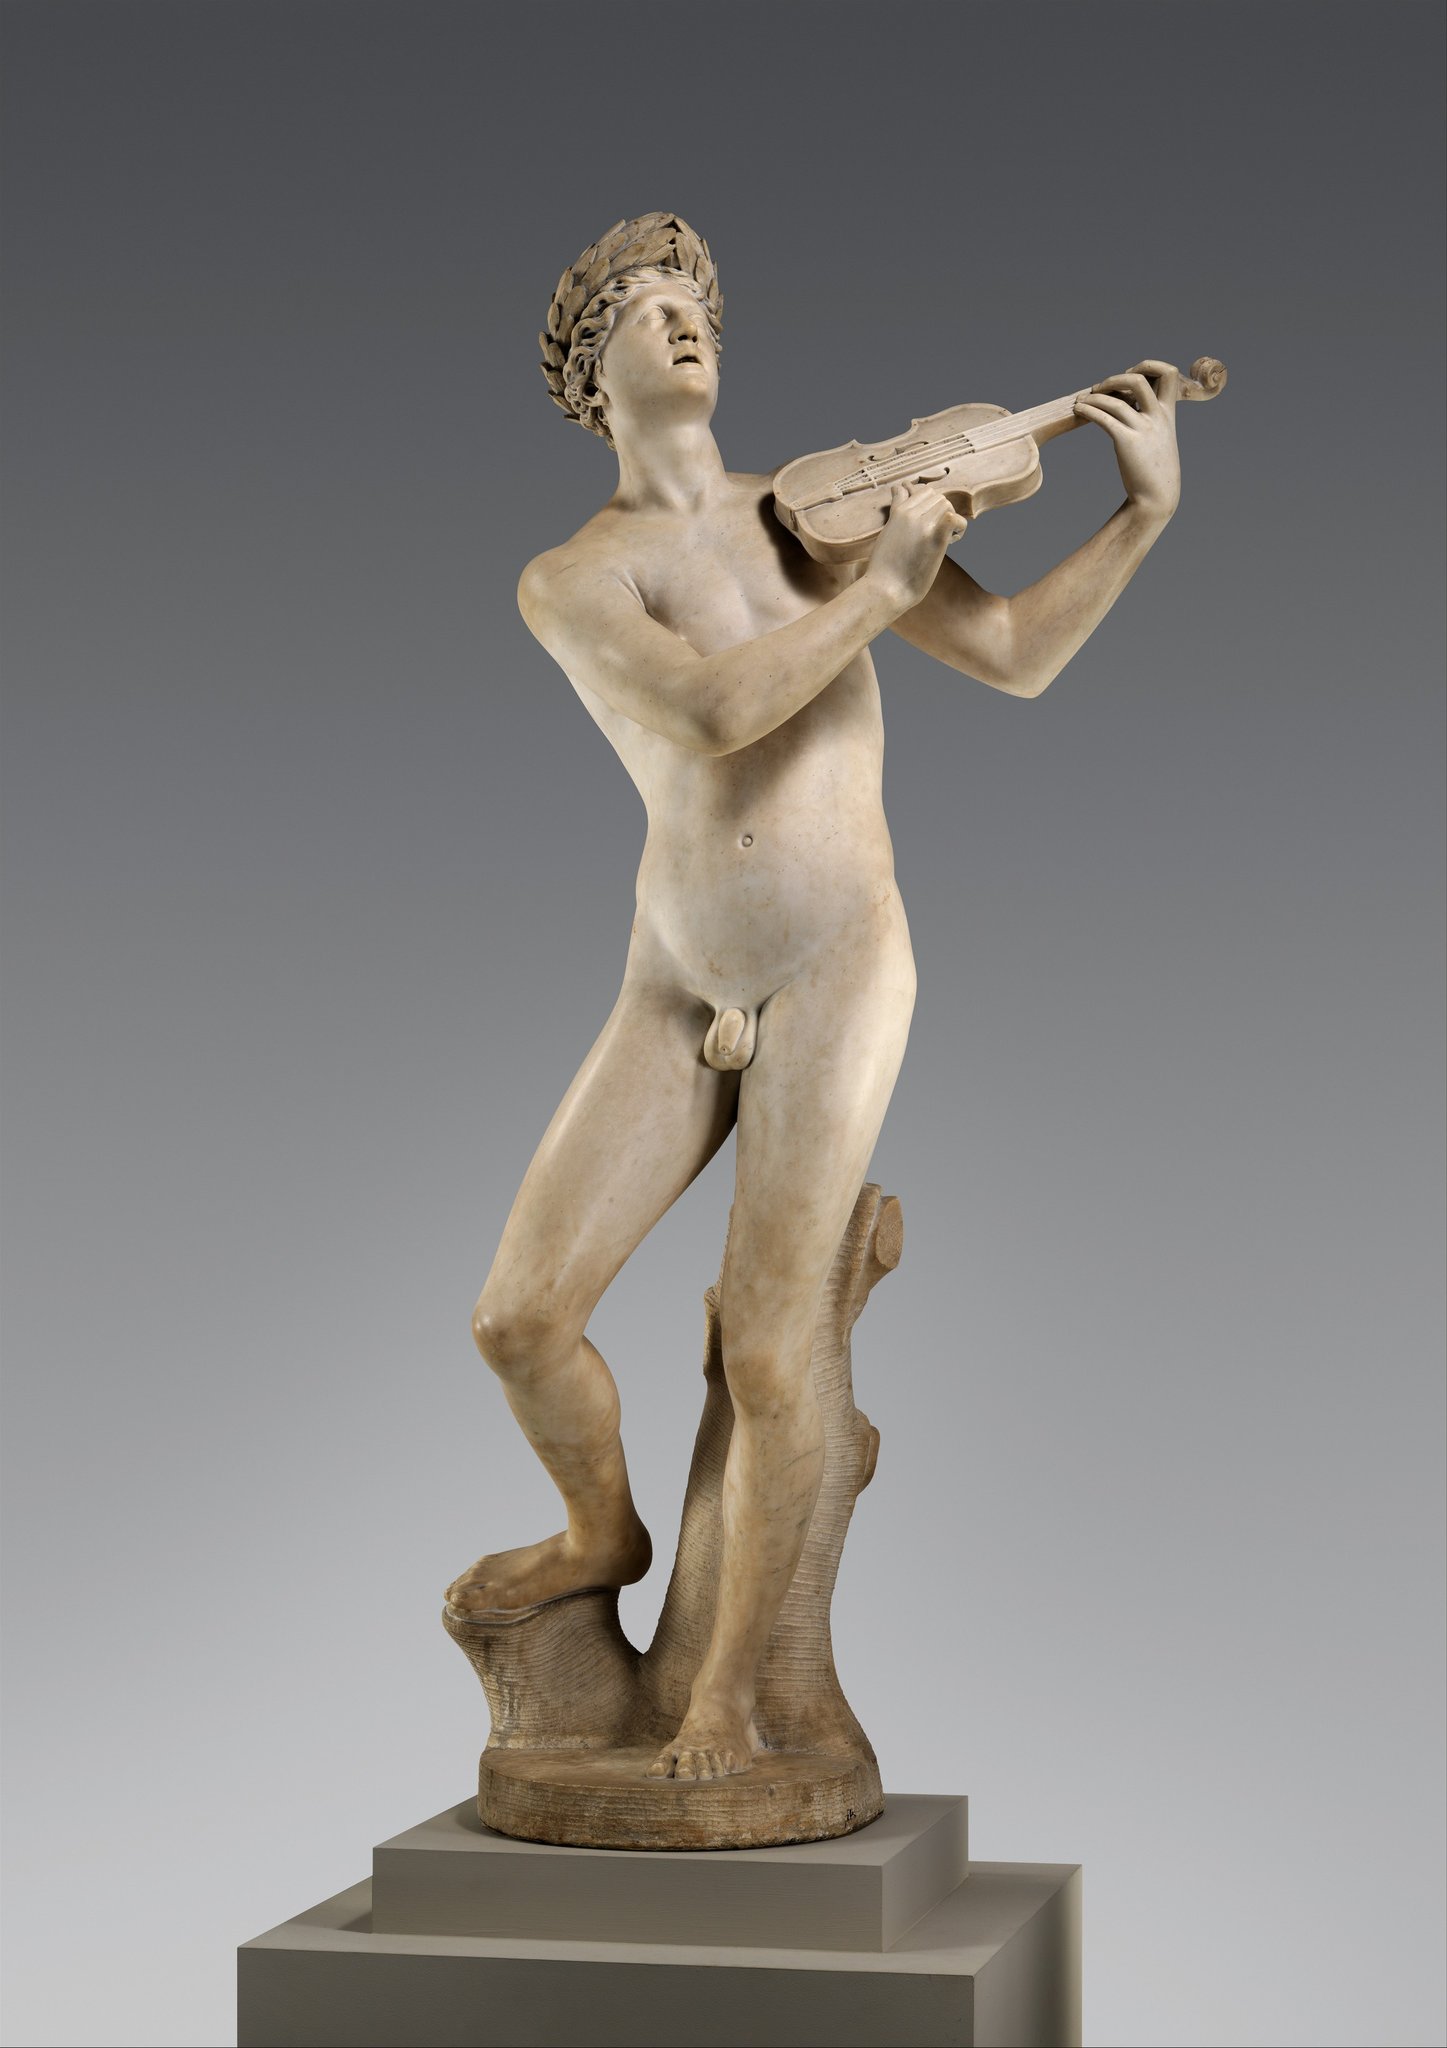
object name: statue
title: Orpheus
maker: cristoforo stati (cristofano da bracciano)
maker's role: artist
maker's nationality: italian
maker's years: 1556-1619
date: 1600-1601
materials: marble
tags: male nudes,violins,orpheus